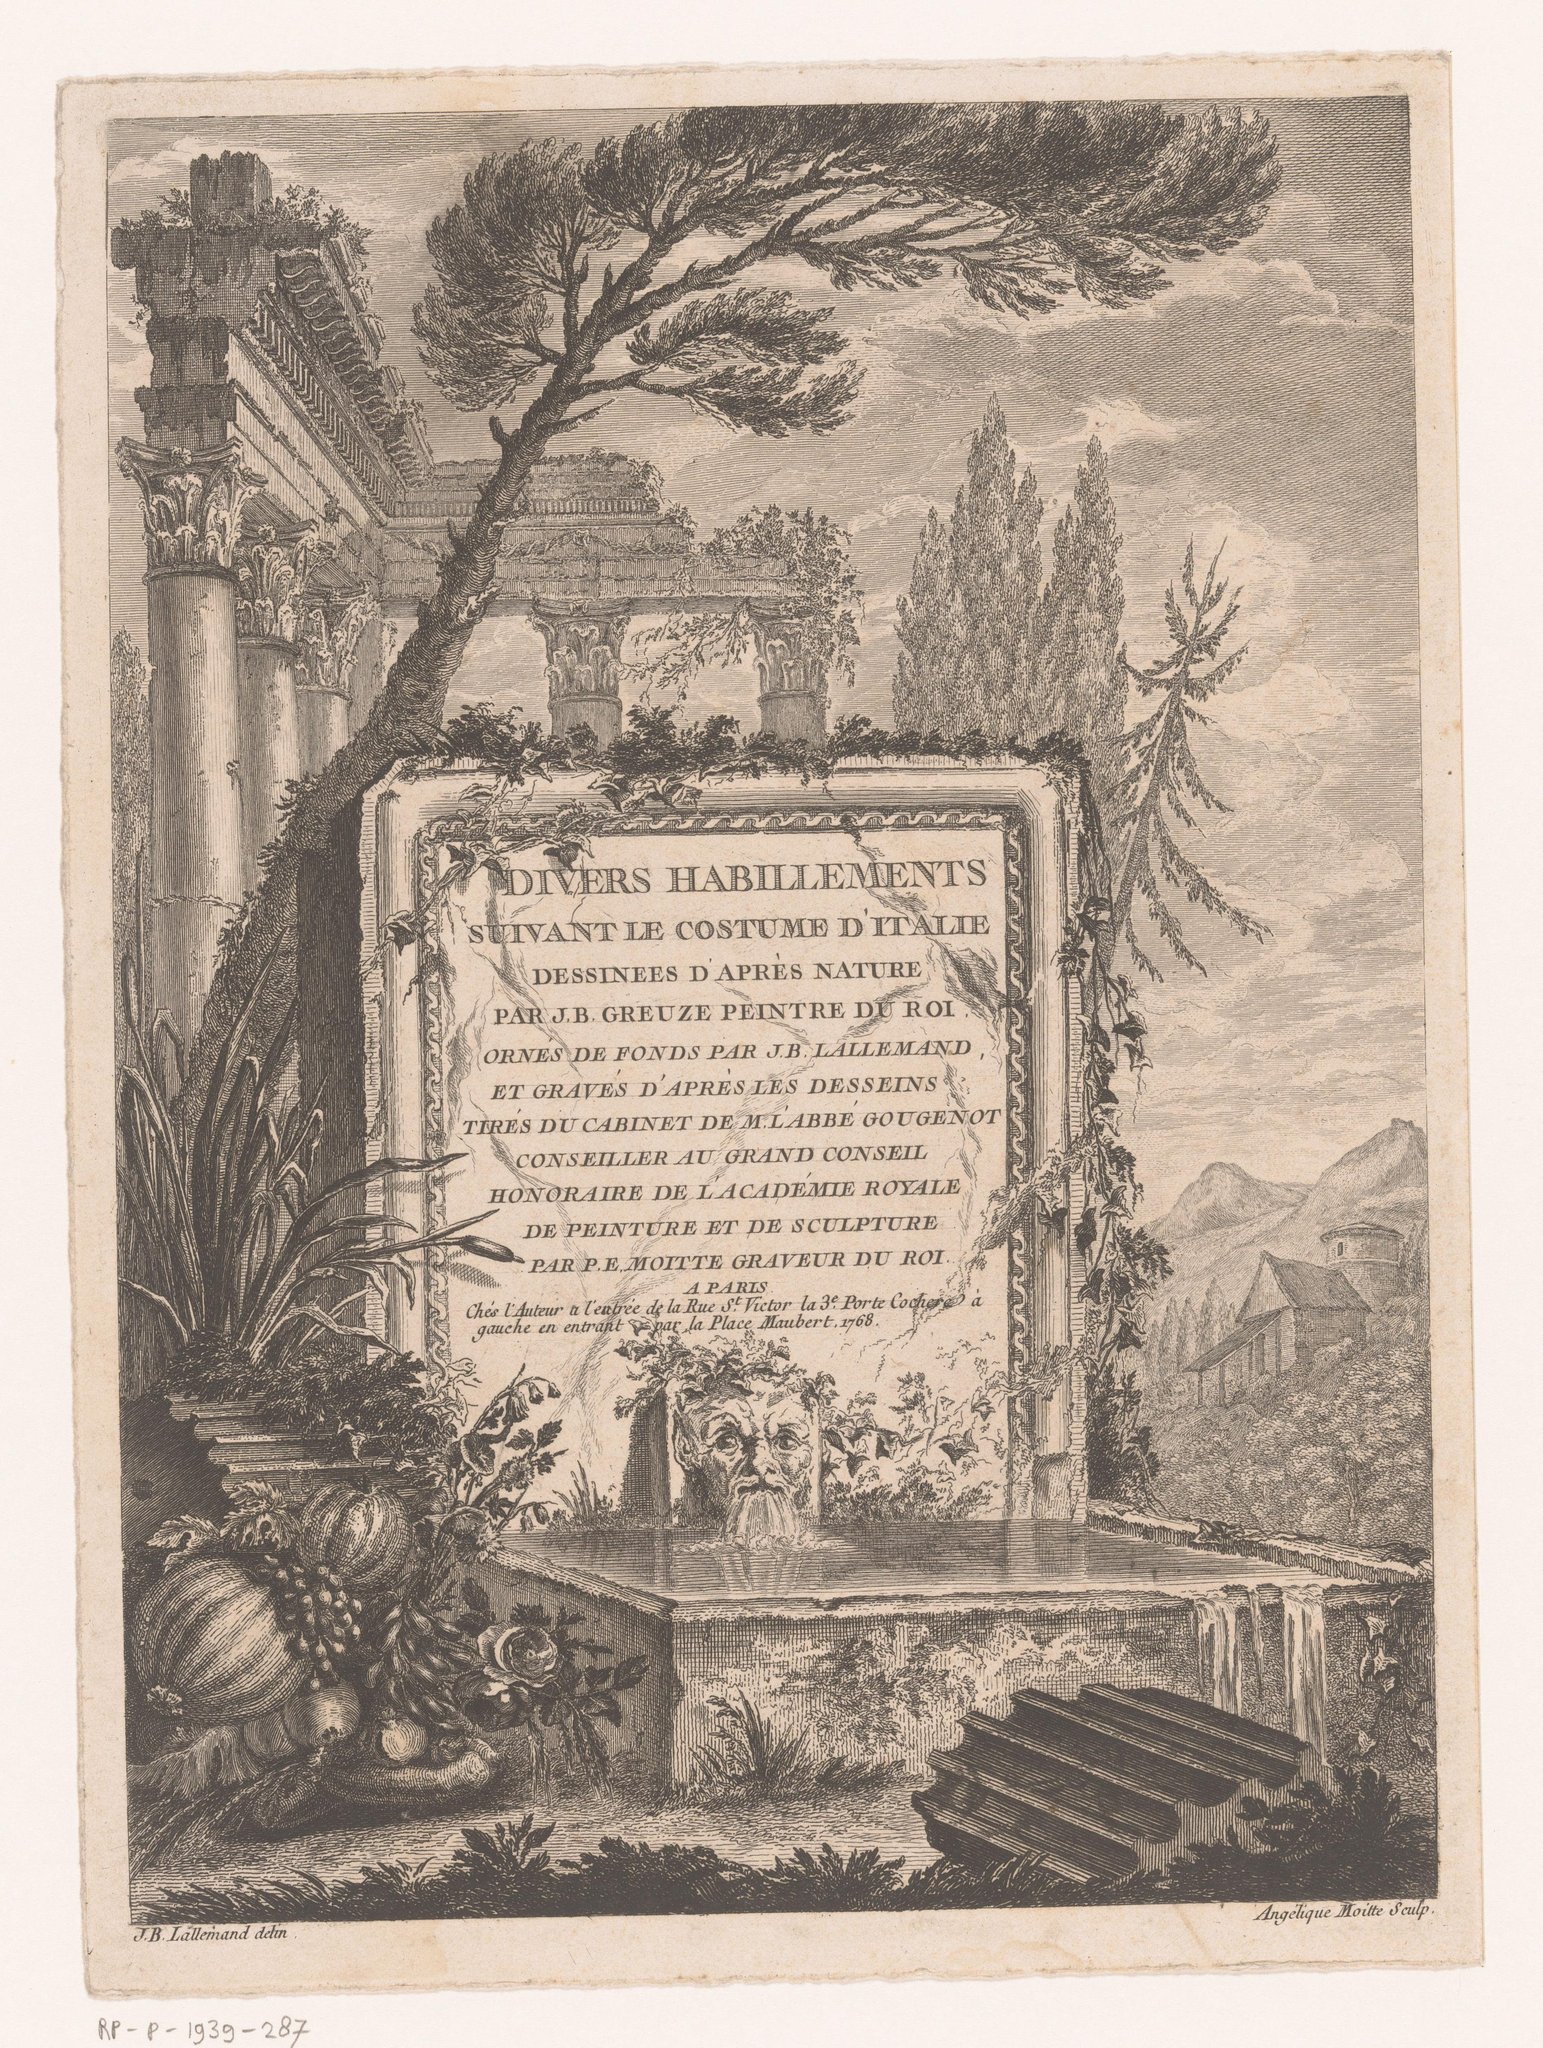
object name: titelprent, frontispice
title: Titelprent met antieke fontein bij een ruïne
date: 1768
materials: paper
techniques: etching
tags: landscape with ruins, folk costume, regional costume, utilitarian, public pump or water fountain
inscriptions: collector's mark: Lugt 2228, inscription: ‘f3,50’, collector's mark: Lugt 2760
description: Titelprent voor een 25-delige serie met figuren in Italiaanse kostuums, naar ontwerpen van Jean Baptiste Greuze.